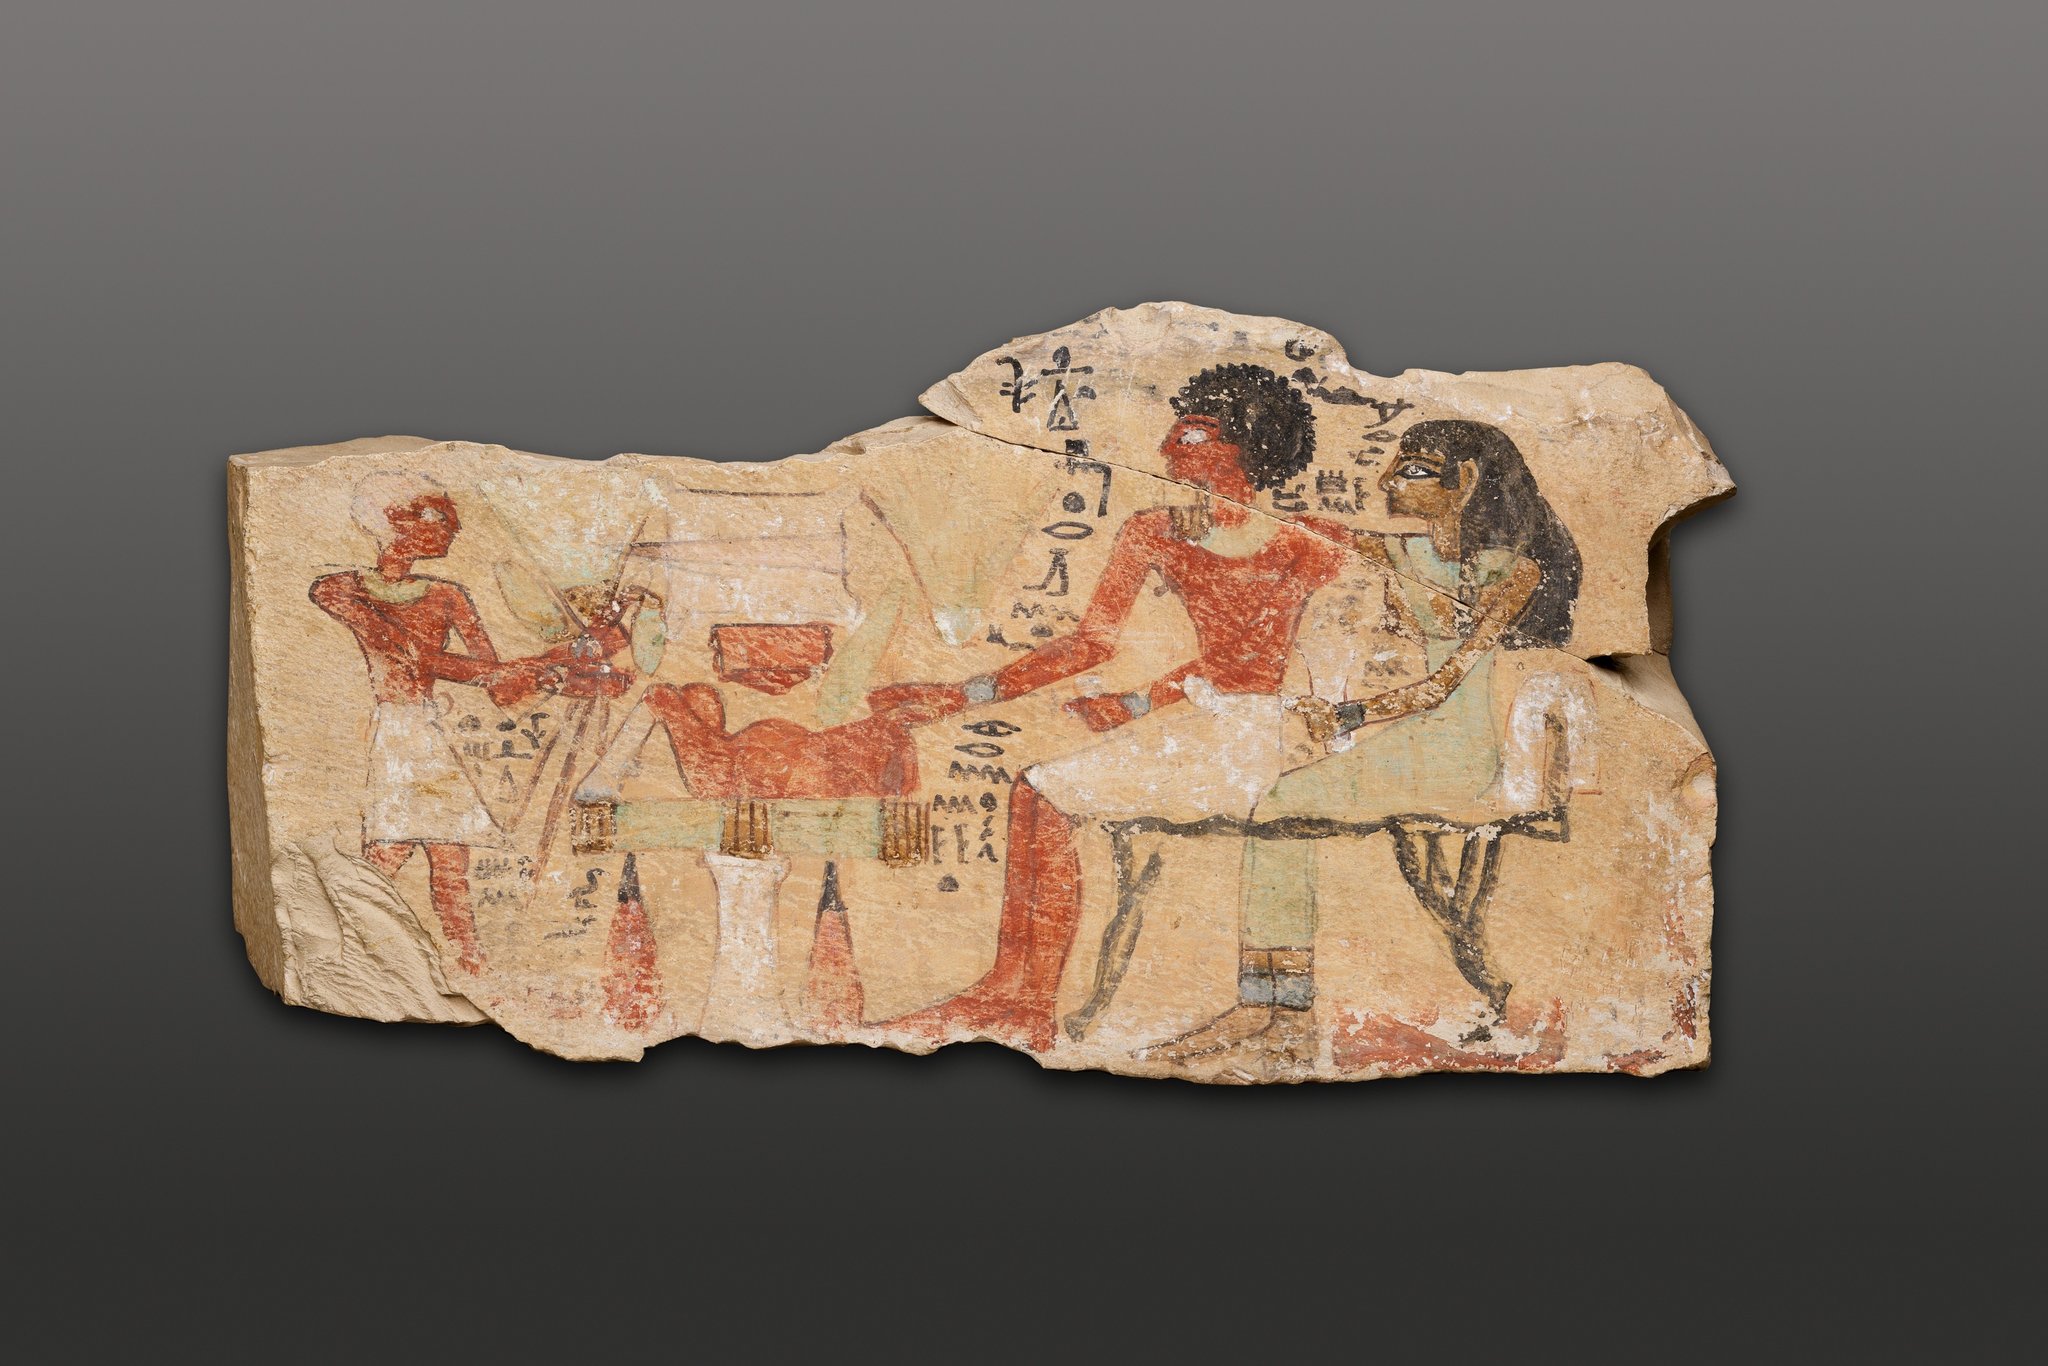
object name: stela, intef, dedetamun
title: Stela of Intef and his wife, Dedetamun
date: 1981-1802 BCE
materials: limestone, paint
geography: egypt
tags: men,women,hieroglyphs